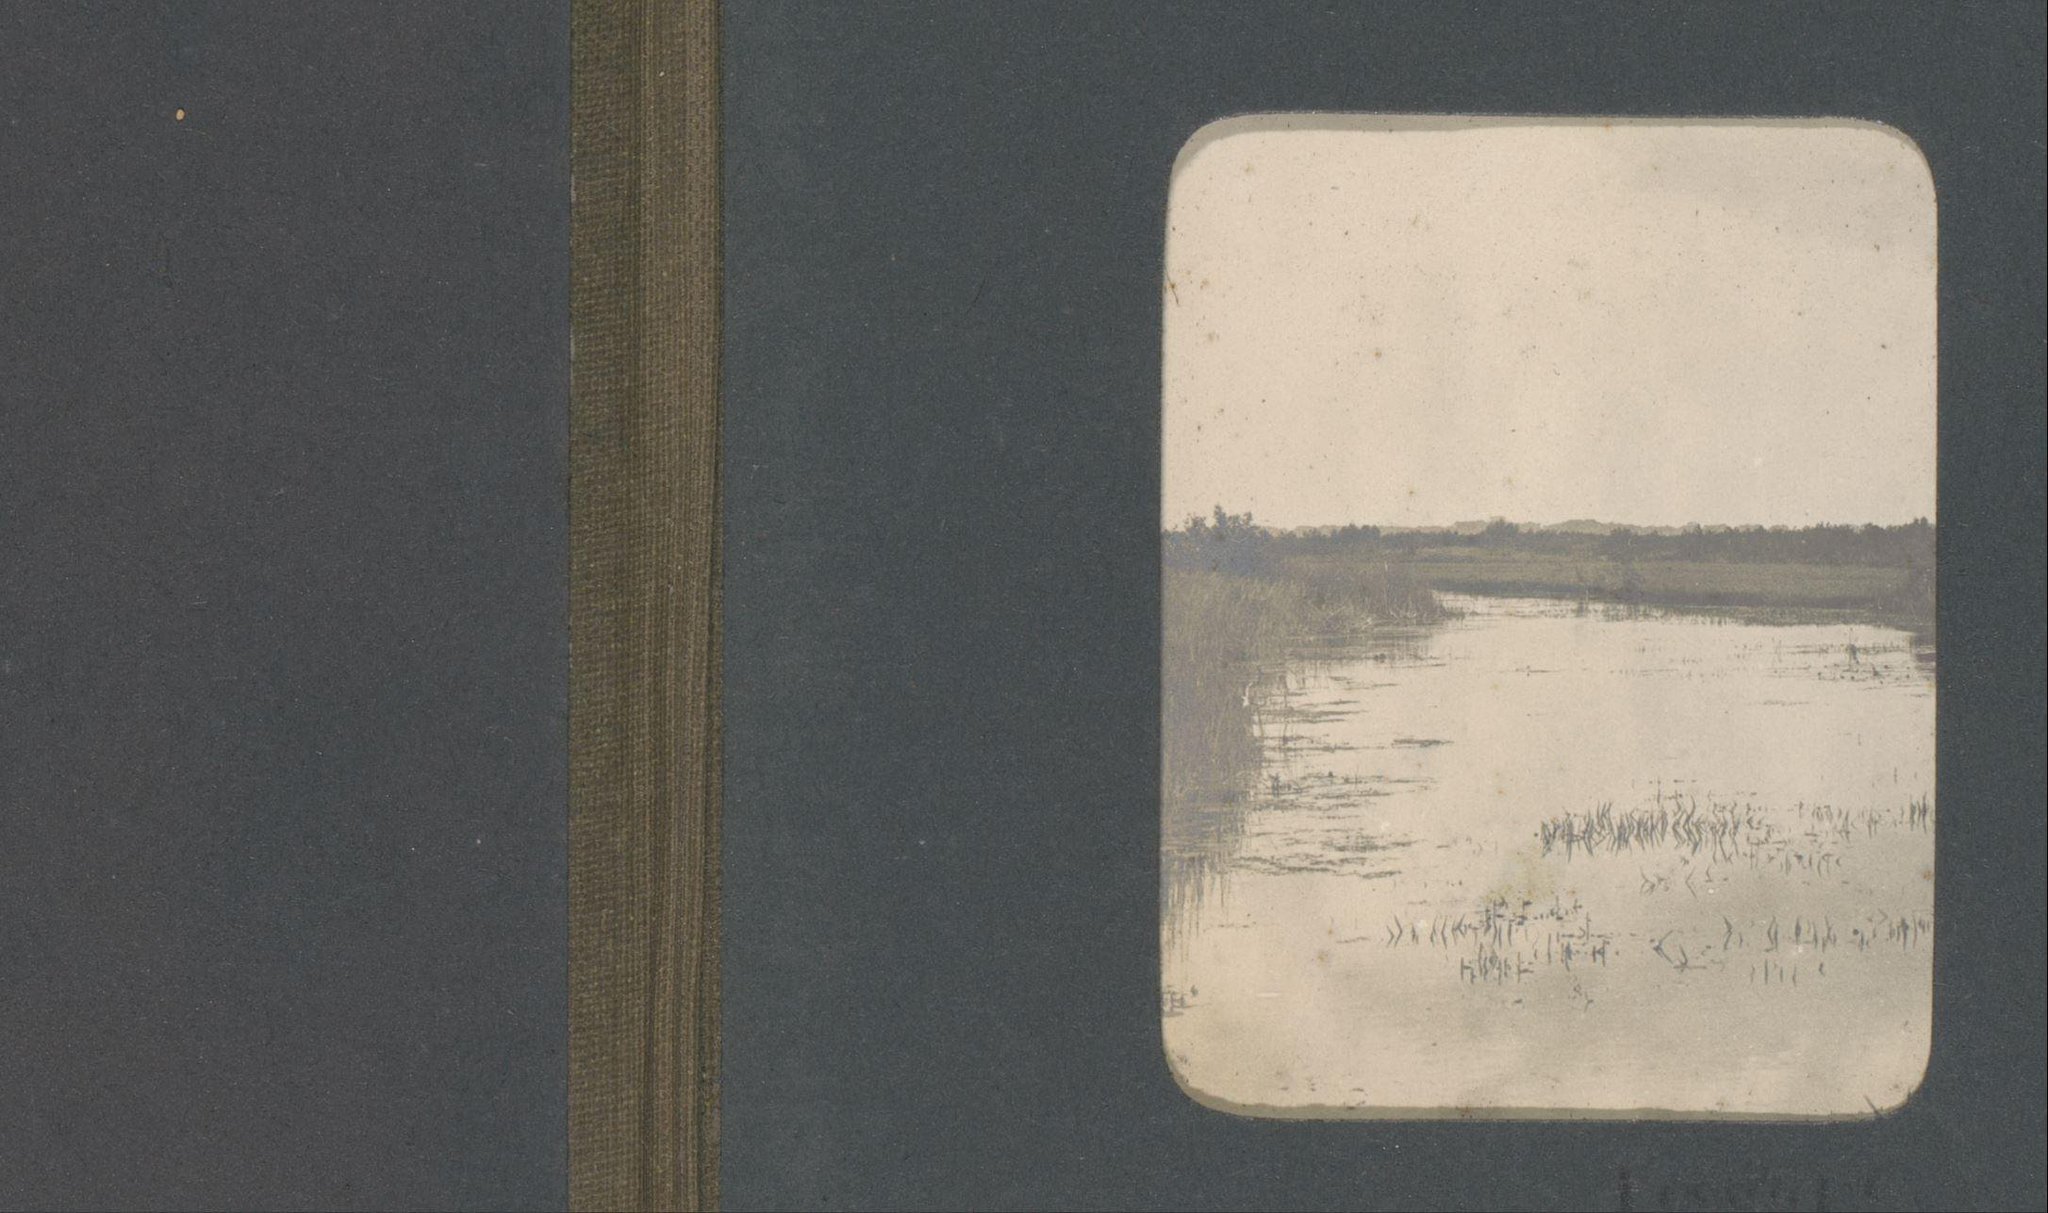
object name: album leaf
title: Landschap met een water en oeverbegroeiing, vermoedelijk in Nederland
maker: Anonymous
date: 1902-1906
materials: cardboard, paper, photographic support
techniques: gelatin silver print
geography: netherlands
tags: landscapes with waters, waterscapes, seascapes (in the temperate zone), netherlands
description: Onderdeel van Reisalbum van een Nederlandse familie met bezienswaardigheden in Europa, Egypte en New York.